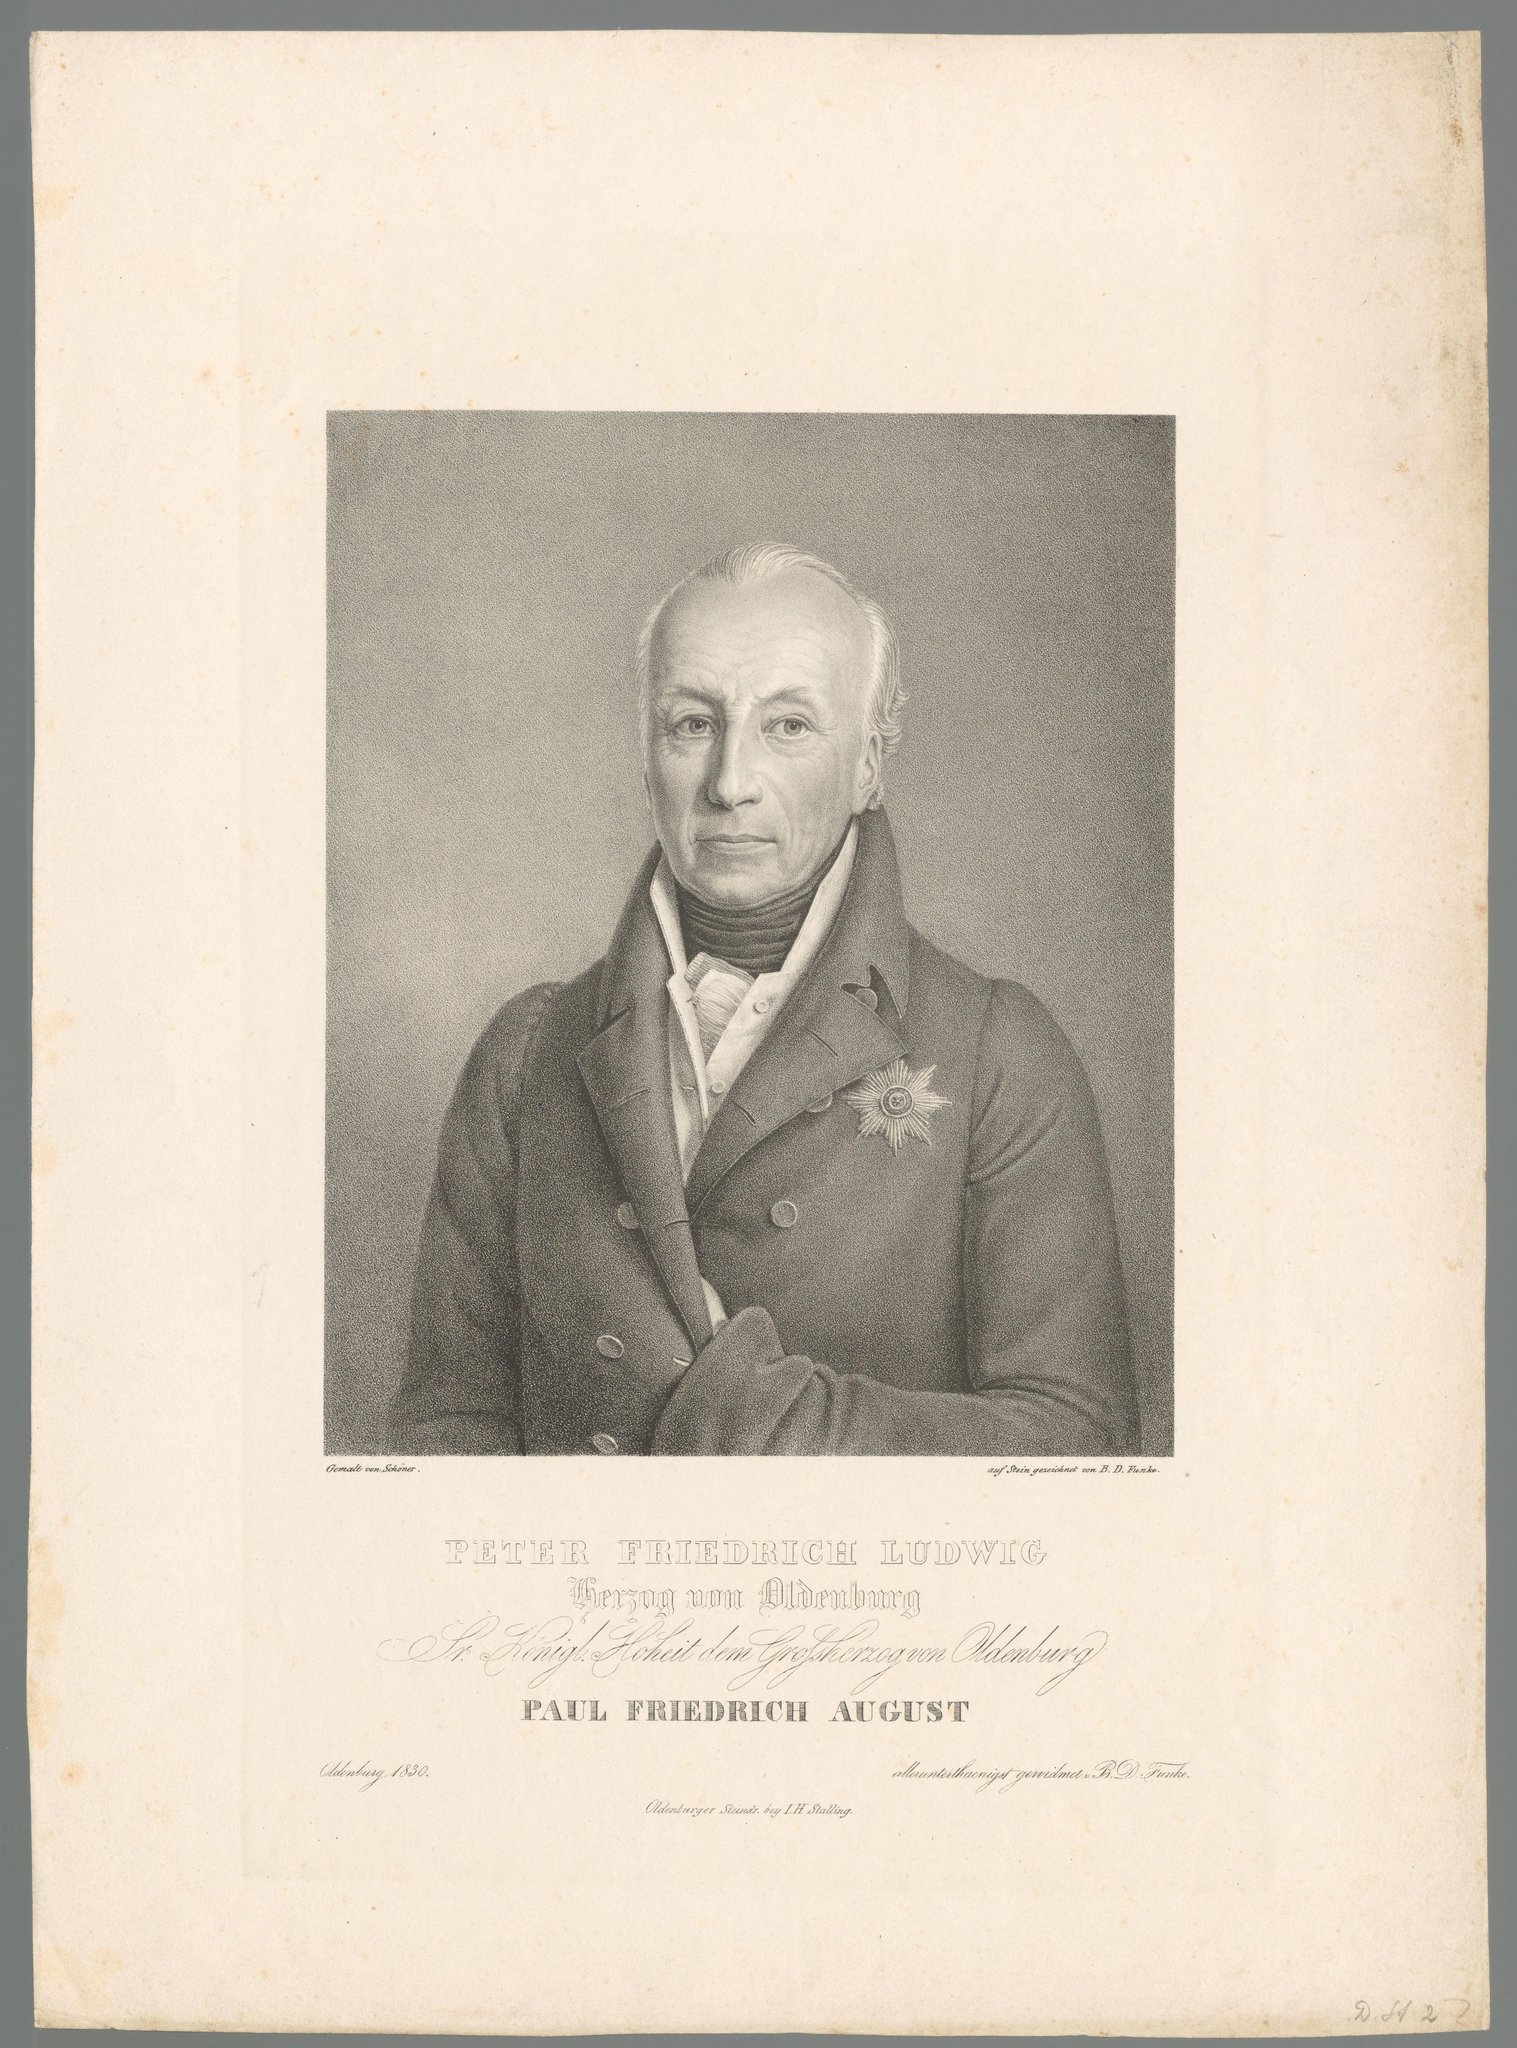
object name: print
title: Portret van Peter Friedrich Ludwig von Oldenburg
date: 1830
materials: paper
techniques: lithograph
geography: oldenburg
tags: adult man, historical persons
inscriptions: collector's mark: Lugt 2228